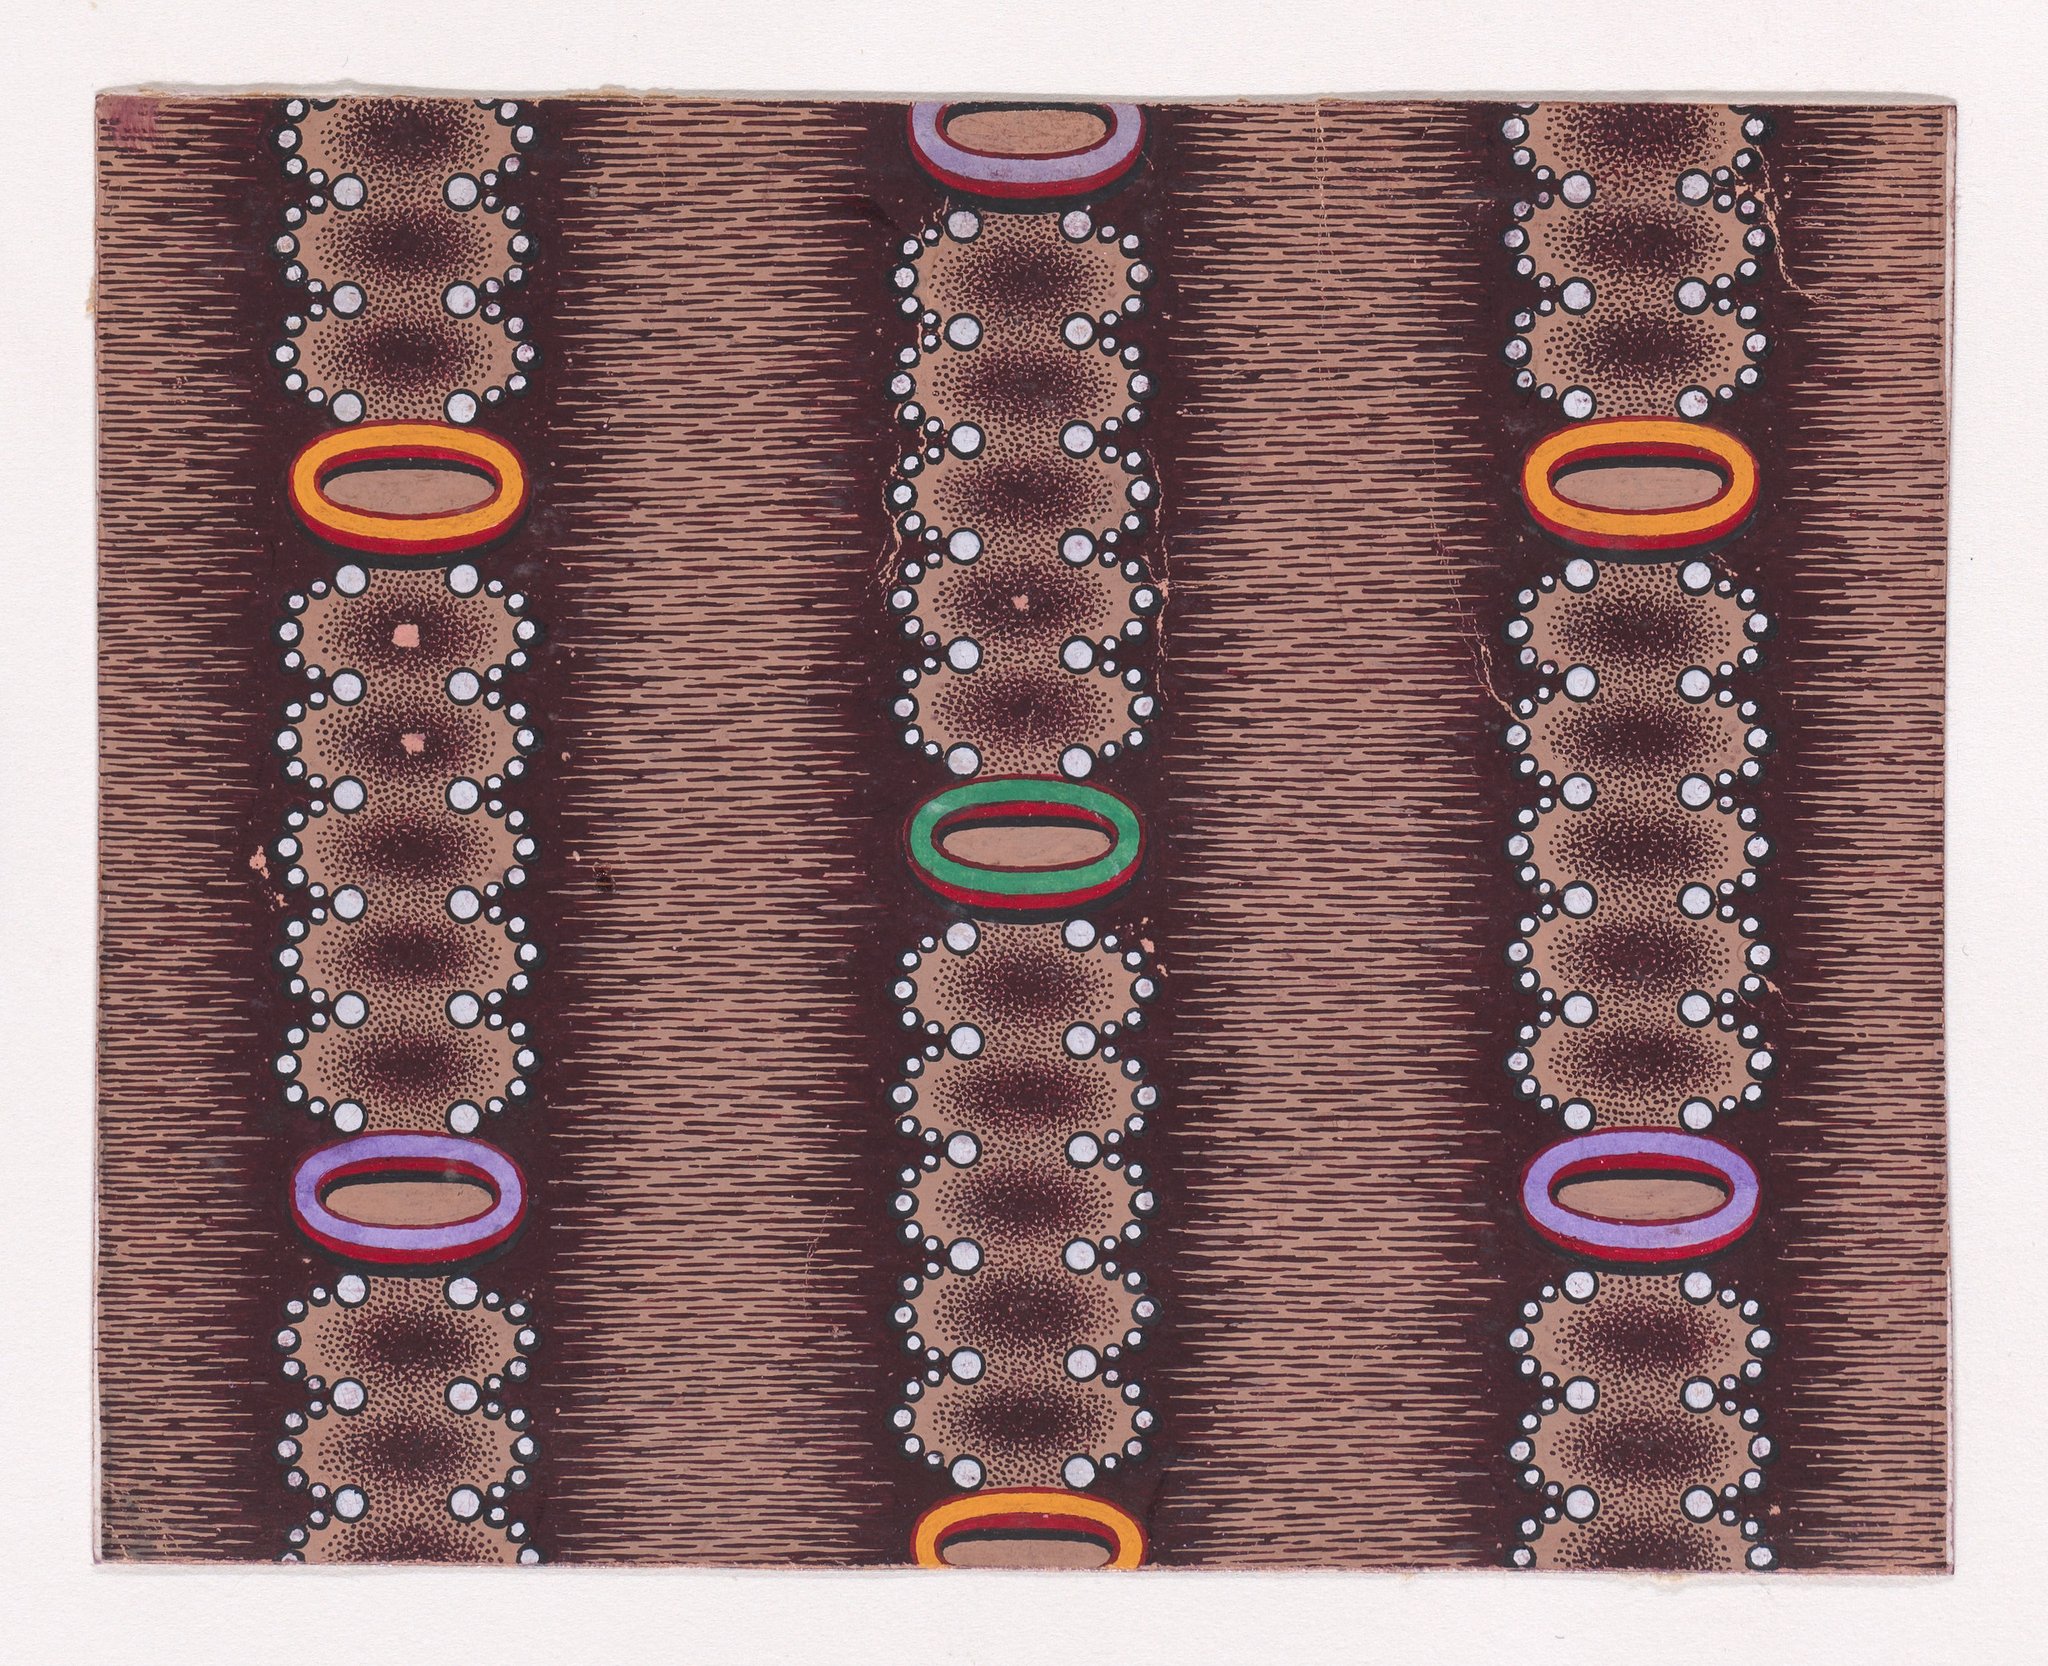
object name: drawing ornament architecture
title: Textile Design with Vertical Garlands Bordered with Pearls Aligned to Form a Pattern of Semicircles Decorated with Oval-Shaped Rings Over a Glitched Background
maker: anonymous, alsatian, 19th century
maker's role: artist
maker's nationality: alsatian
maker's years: 1800-1900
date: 1840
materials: gouache